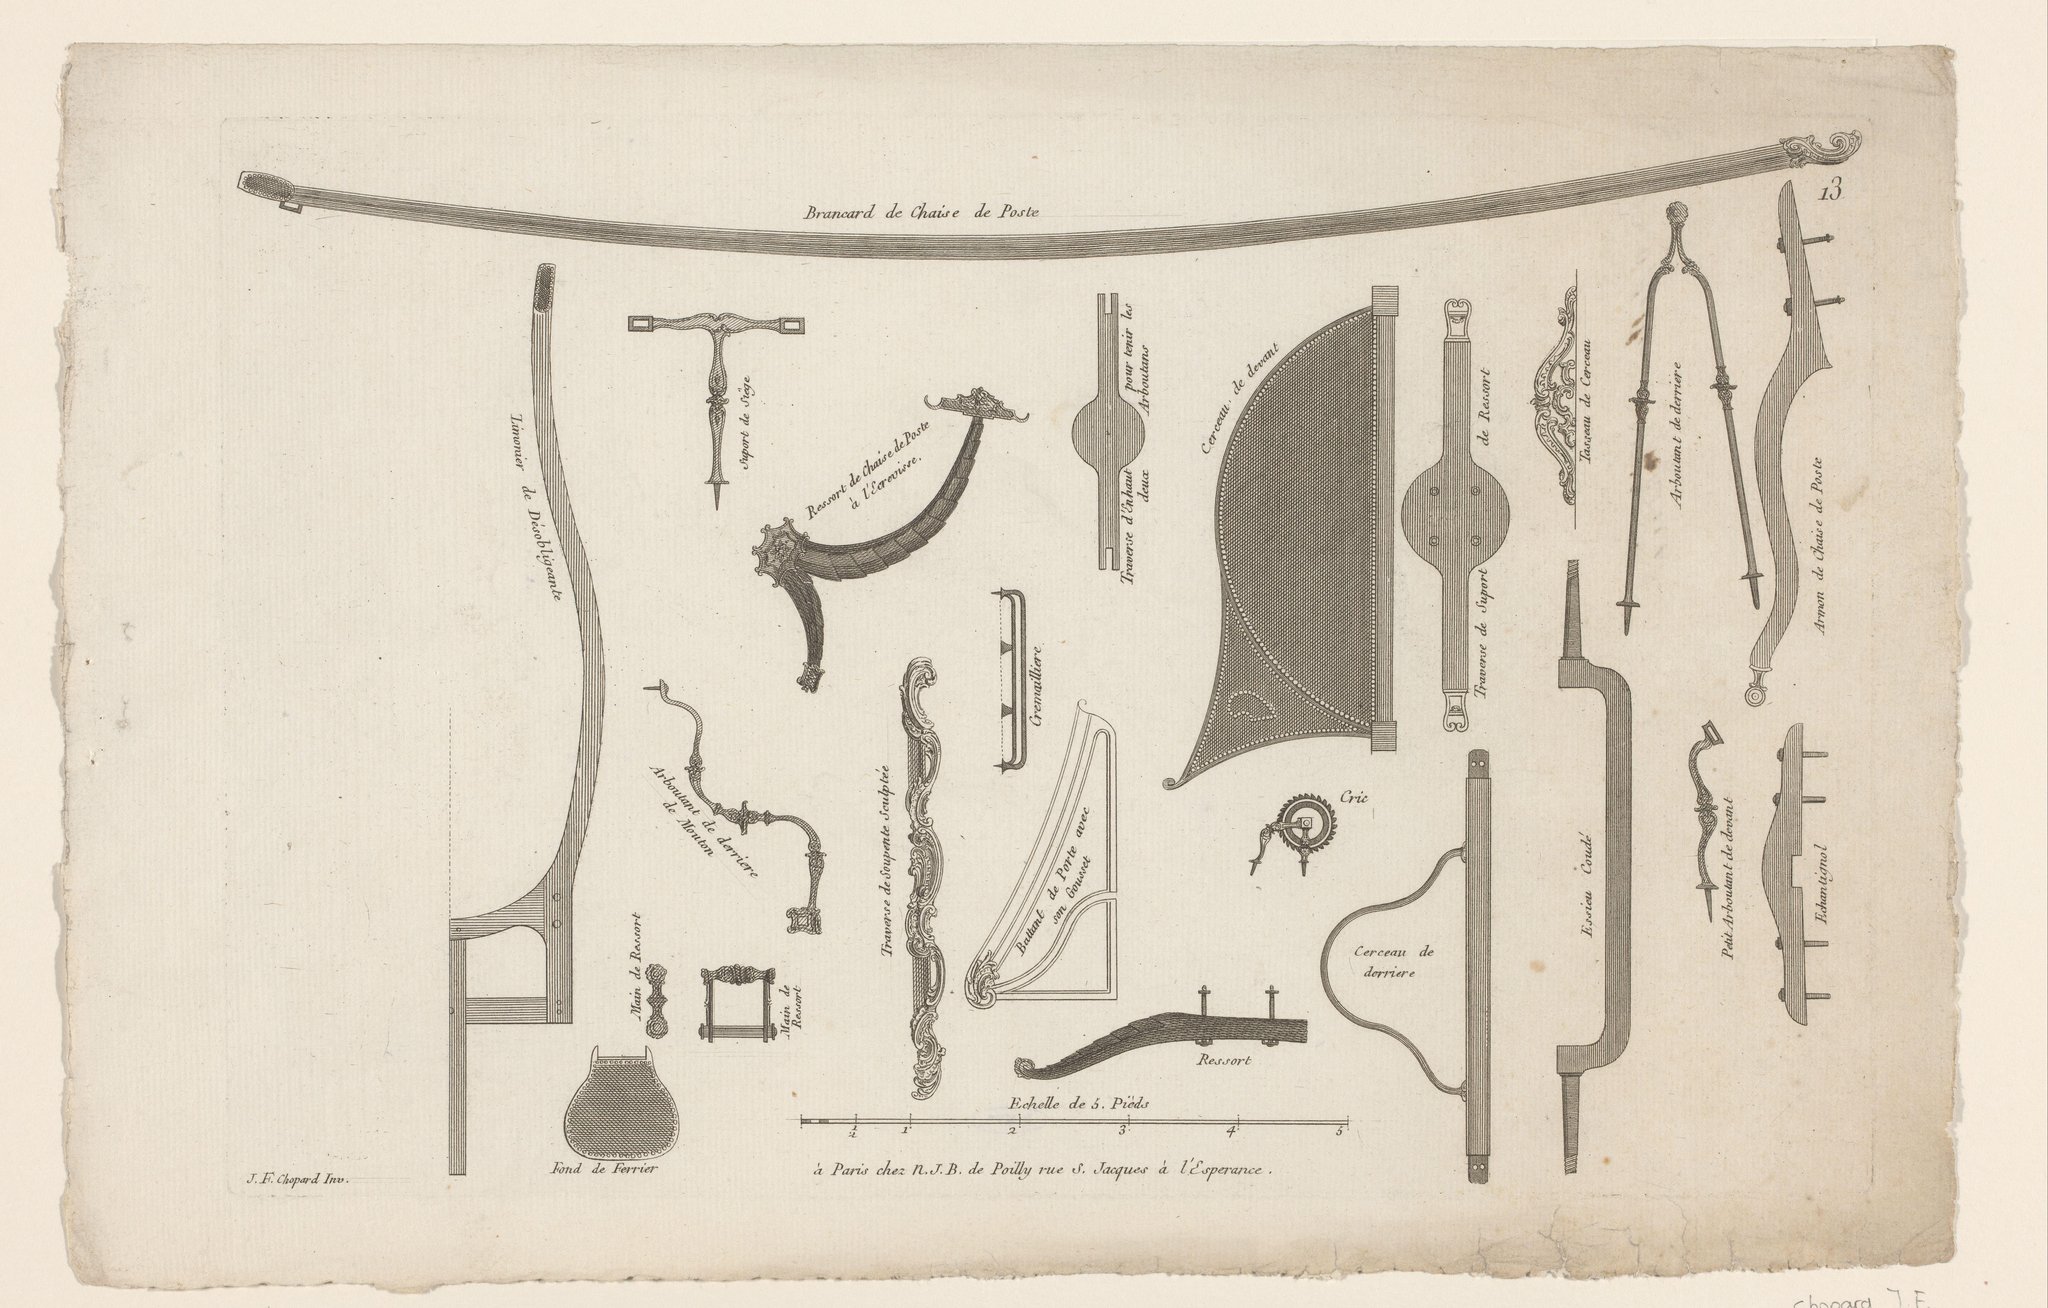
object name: print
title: Modèles de voitures Louis XV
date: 1740-1758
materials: paper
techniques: engraving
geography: paris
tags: four-wheeled, animal-drawn vehicle, e.g.: cab, carriage, coach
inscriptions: collector's mark: Lugt 2228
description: Prenten RP-P-1949-744A t/m K zijn aan elkaar gebonden.